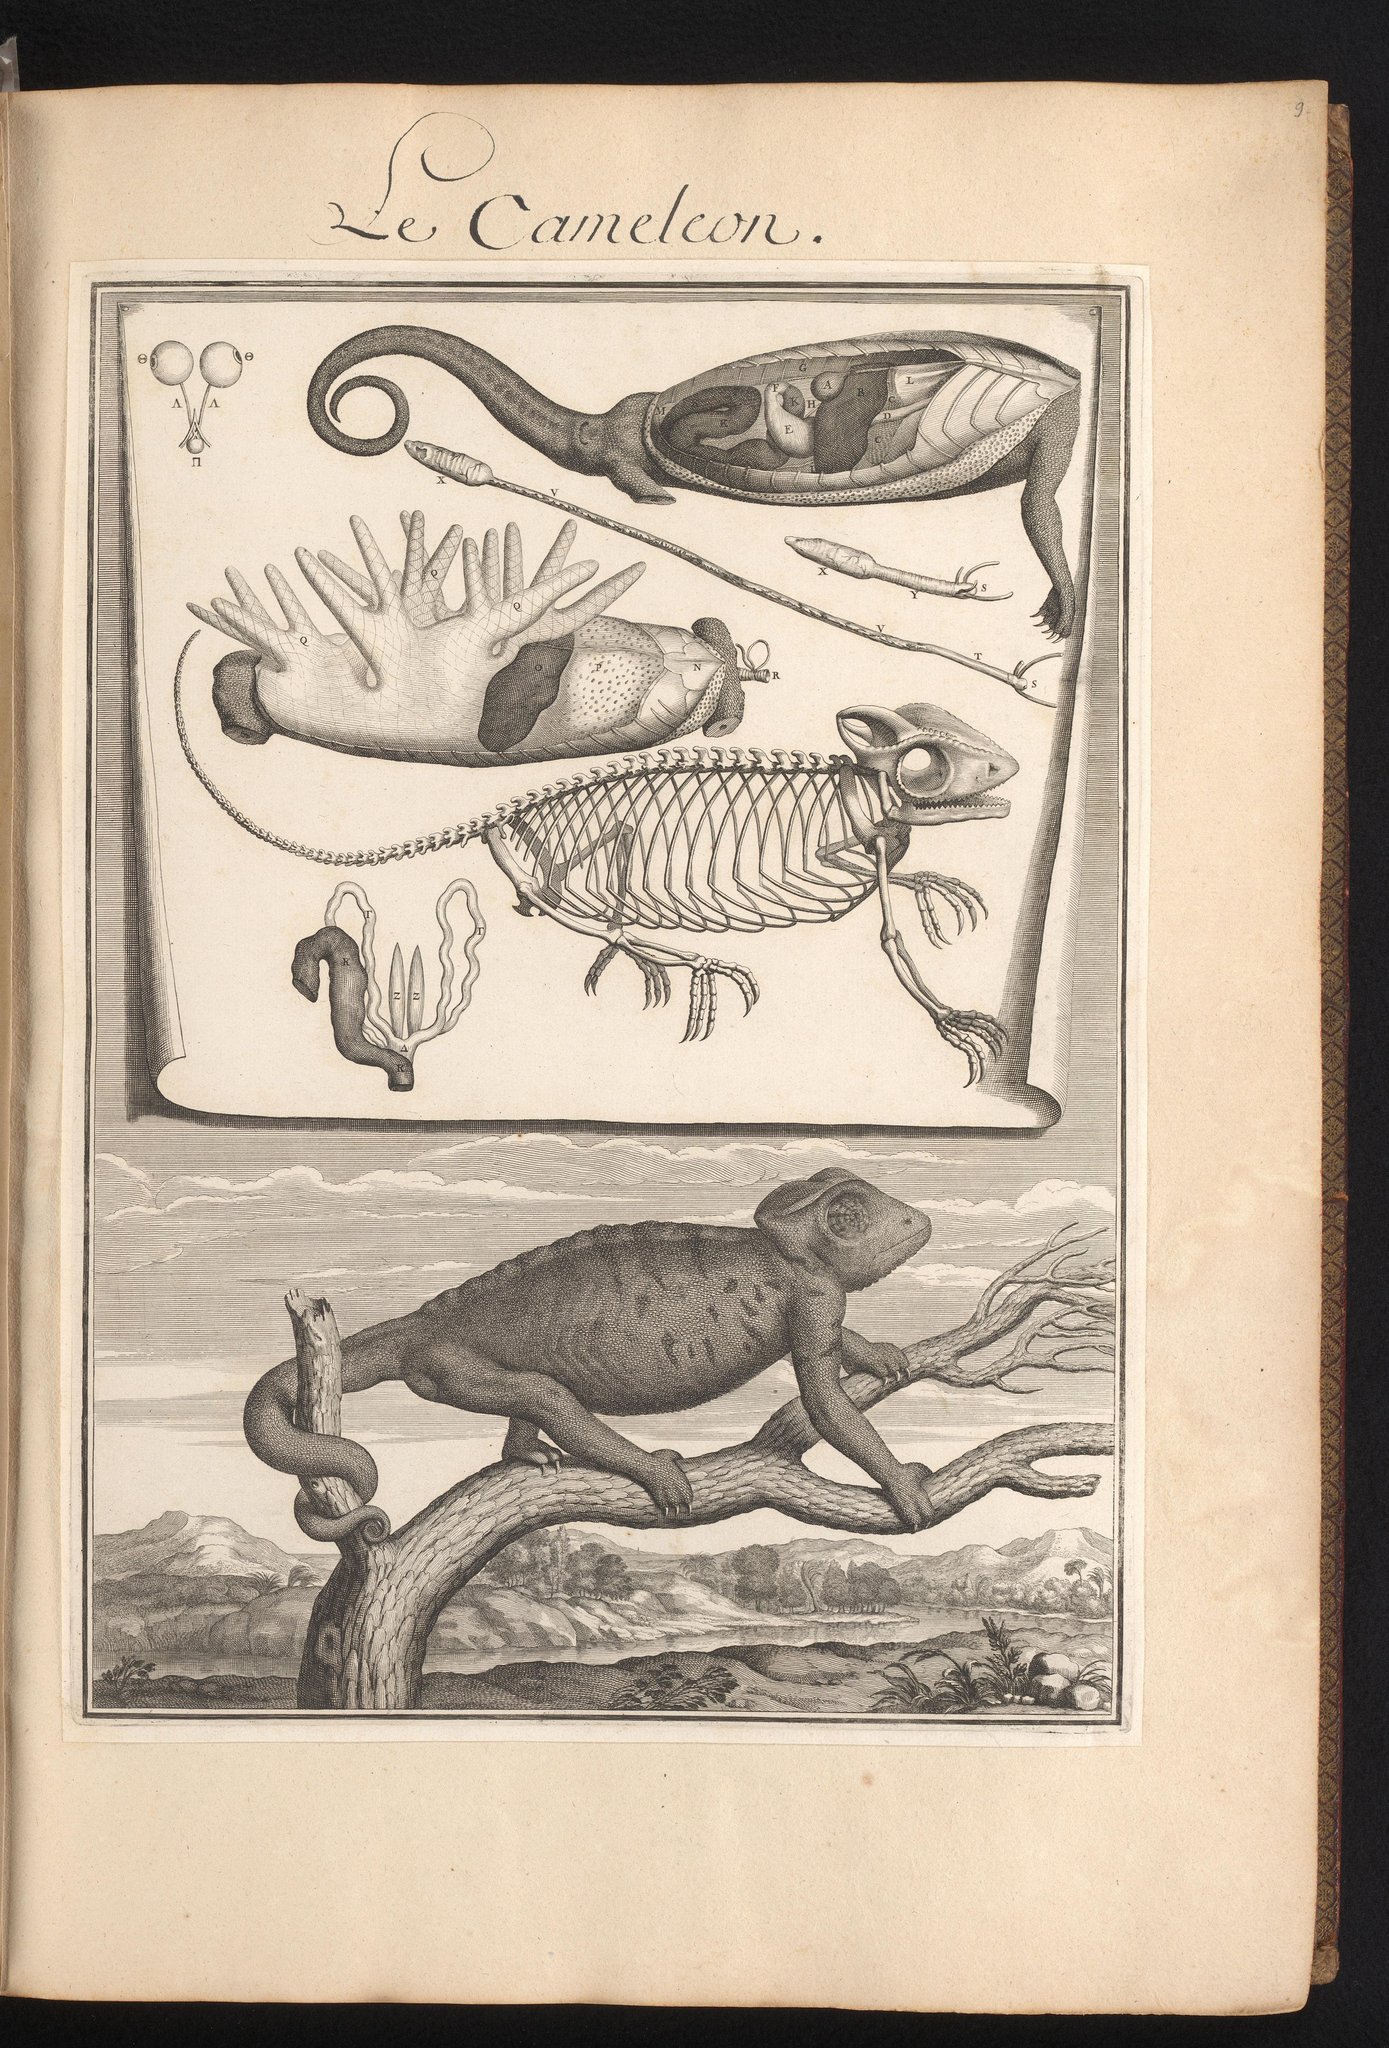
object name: print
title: Kameleon op een tak in een landschap met bovenaan op een blad de organen en botten van het dier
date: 1669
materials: ink, paper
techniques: engraving, etching, pen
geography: paris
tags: dissection, lizards: chameleon (+ anatomy of animals), lizards: chameleon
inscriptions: inscription: ‘Le Cameleon.’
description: Prent uit: Perrault, Claude. Description anatomique d'un cameleon, d'un castor, d'un dromadaire, d'un ours et d'une gazelle. Parijs: Frédéric Léonard, 1669.